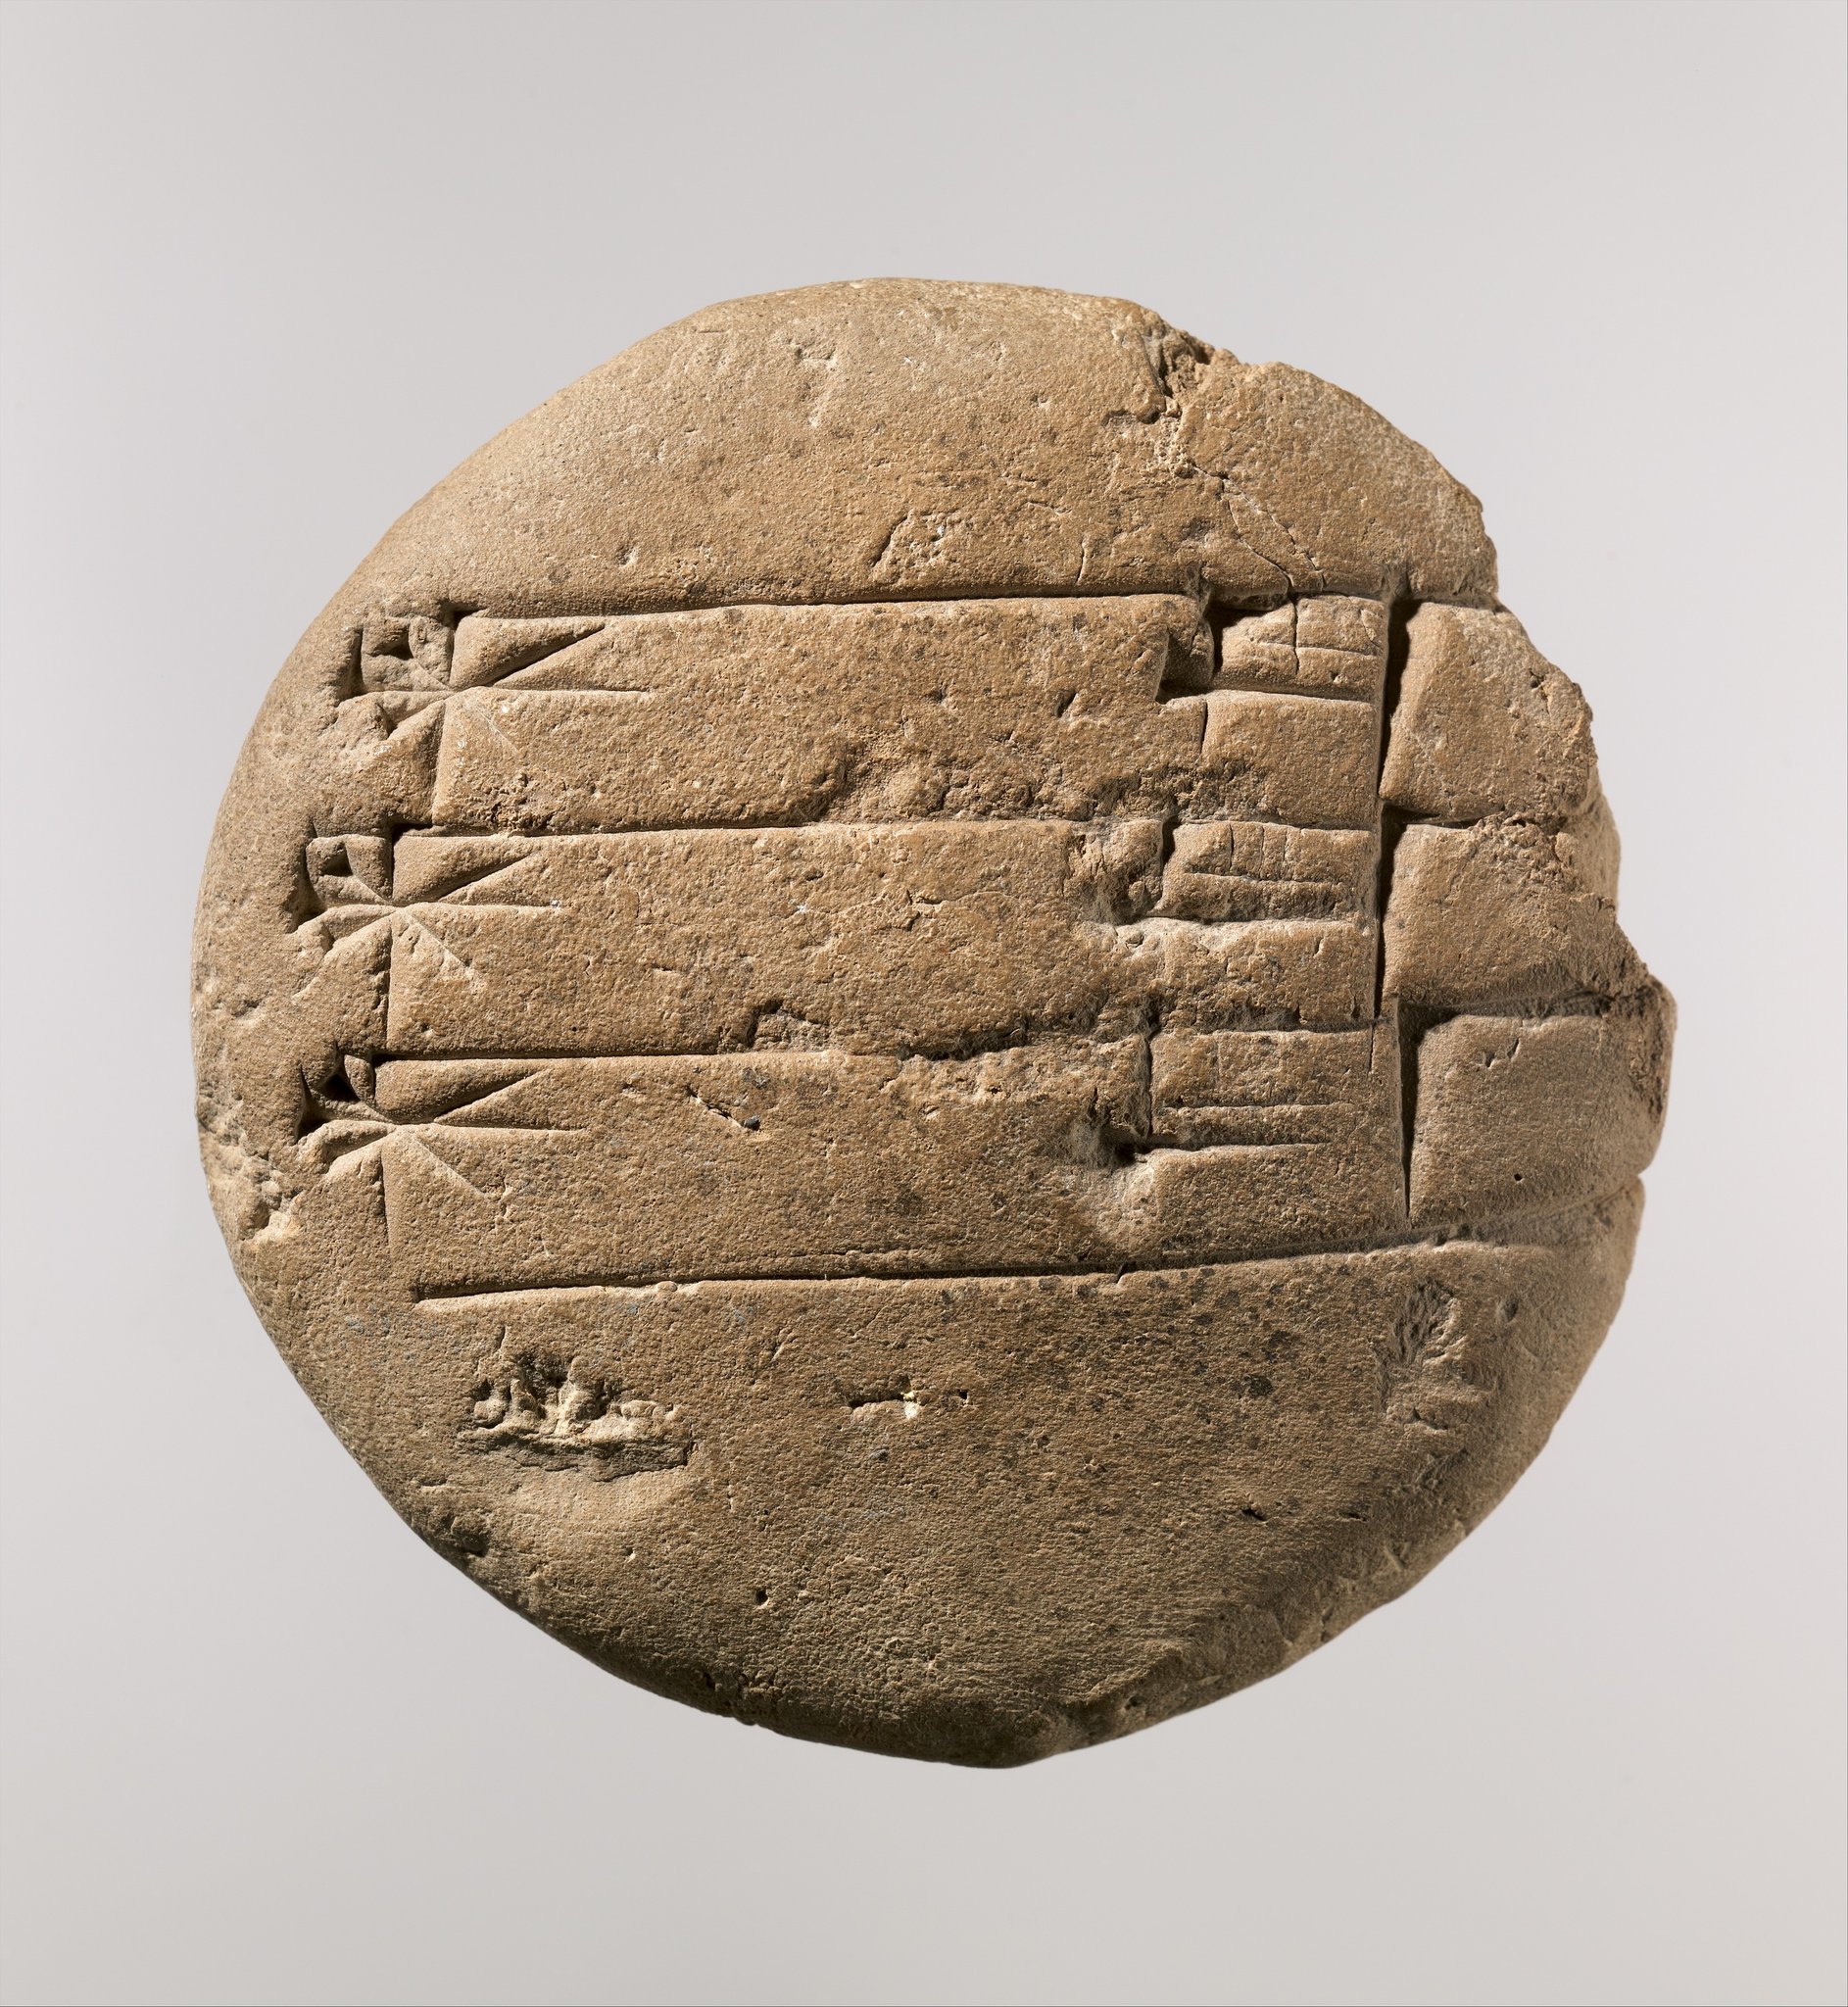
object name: cuneiform tablet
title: Cuneiform tablet: student exercise tablet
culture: babylonian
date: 2000-1501 BCE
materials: clay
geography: mesopotamia